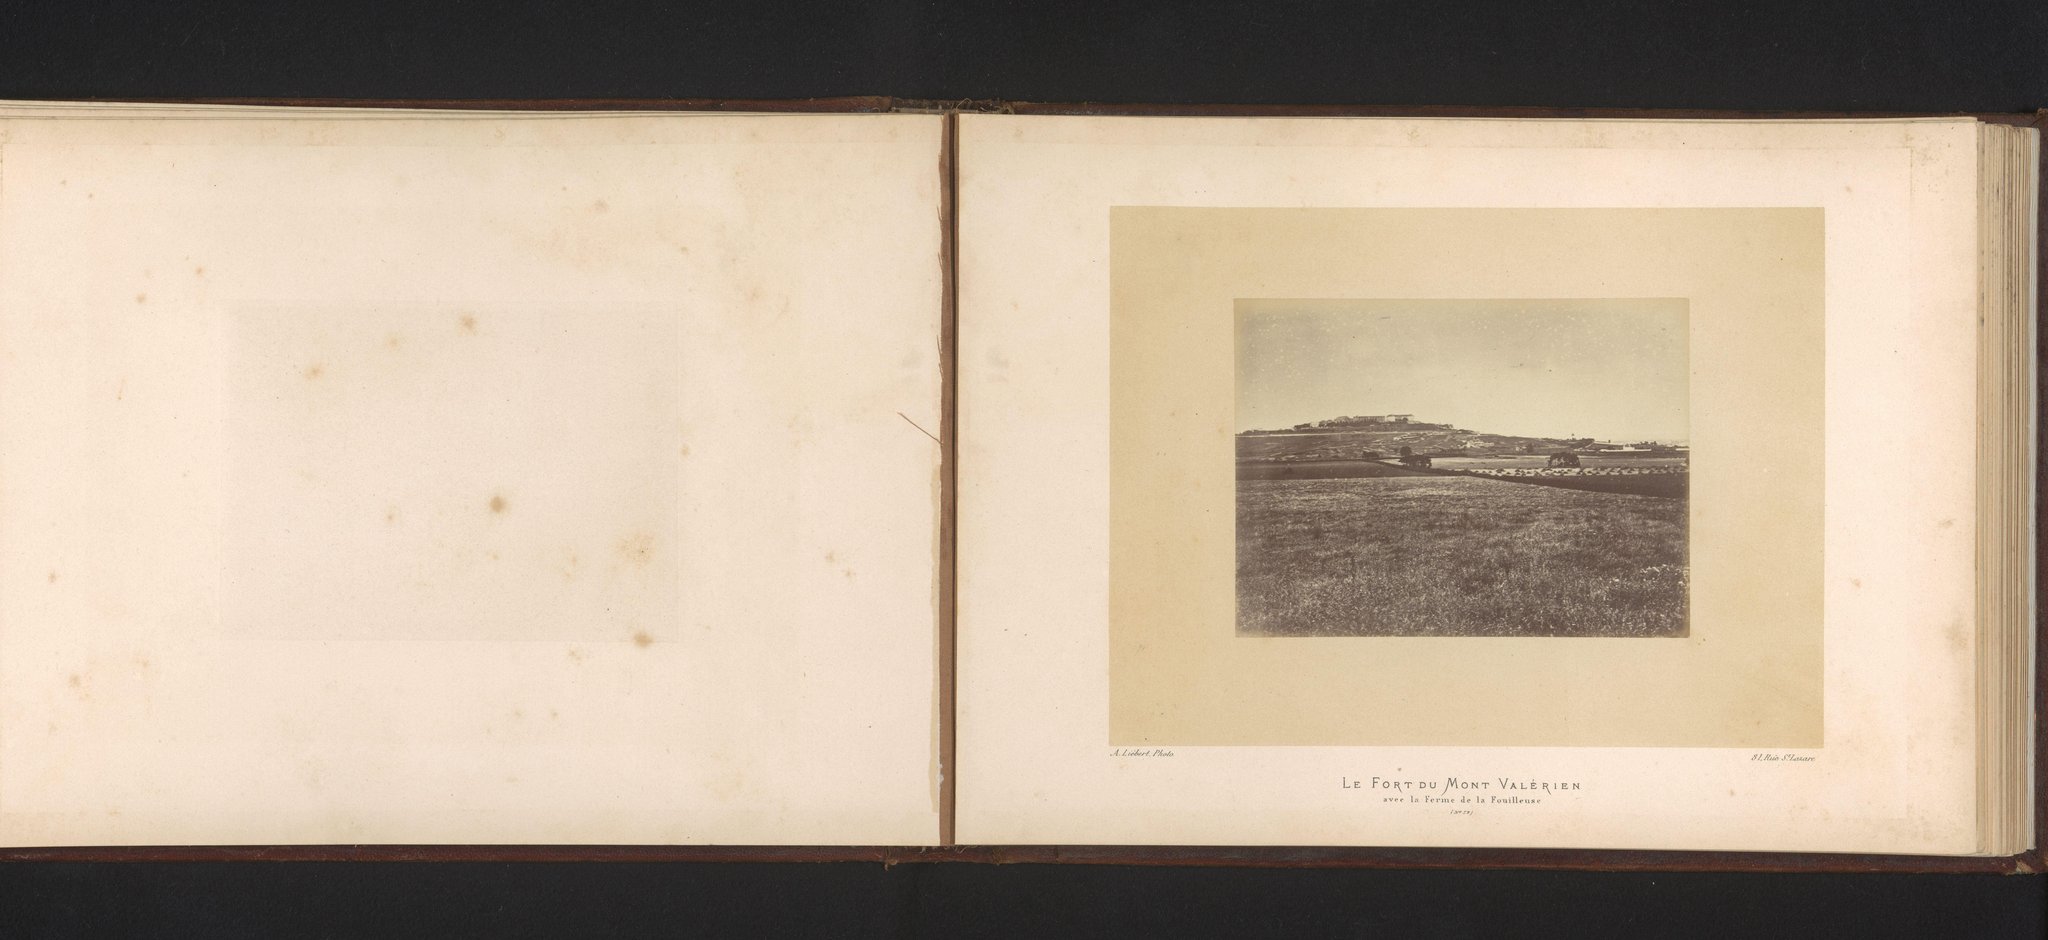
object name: page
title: Gezicht op het fort van Mont-Valérien in Suresnes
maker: alphonse-justin liébert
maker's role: fotograaf, marinier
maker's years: 1827-1914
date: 1871-1872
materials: photographic support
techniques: albumen print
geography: suresnes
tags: fortress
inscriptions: address: ‘31, Rue St. Lazare’, number: ‘(No. 72)’